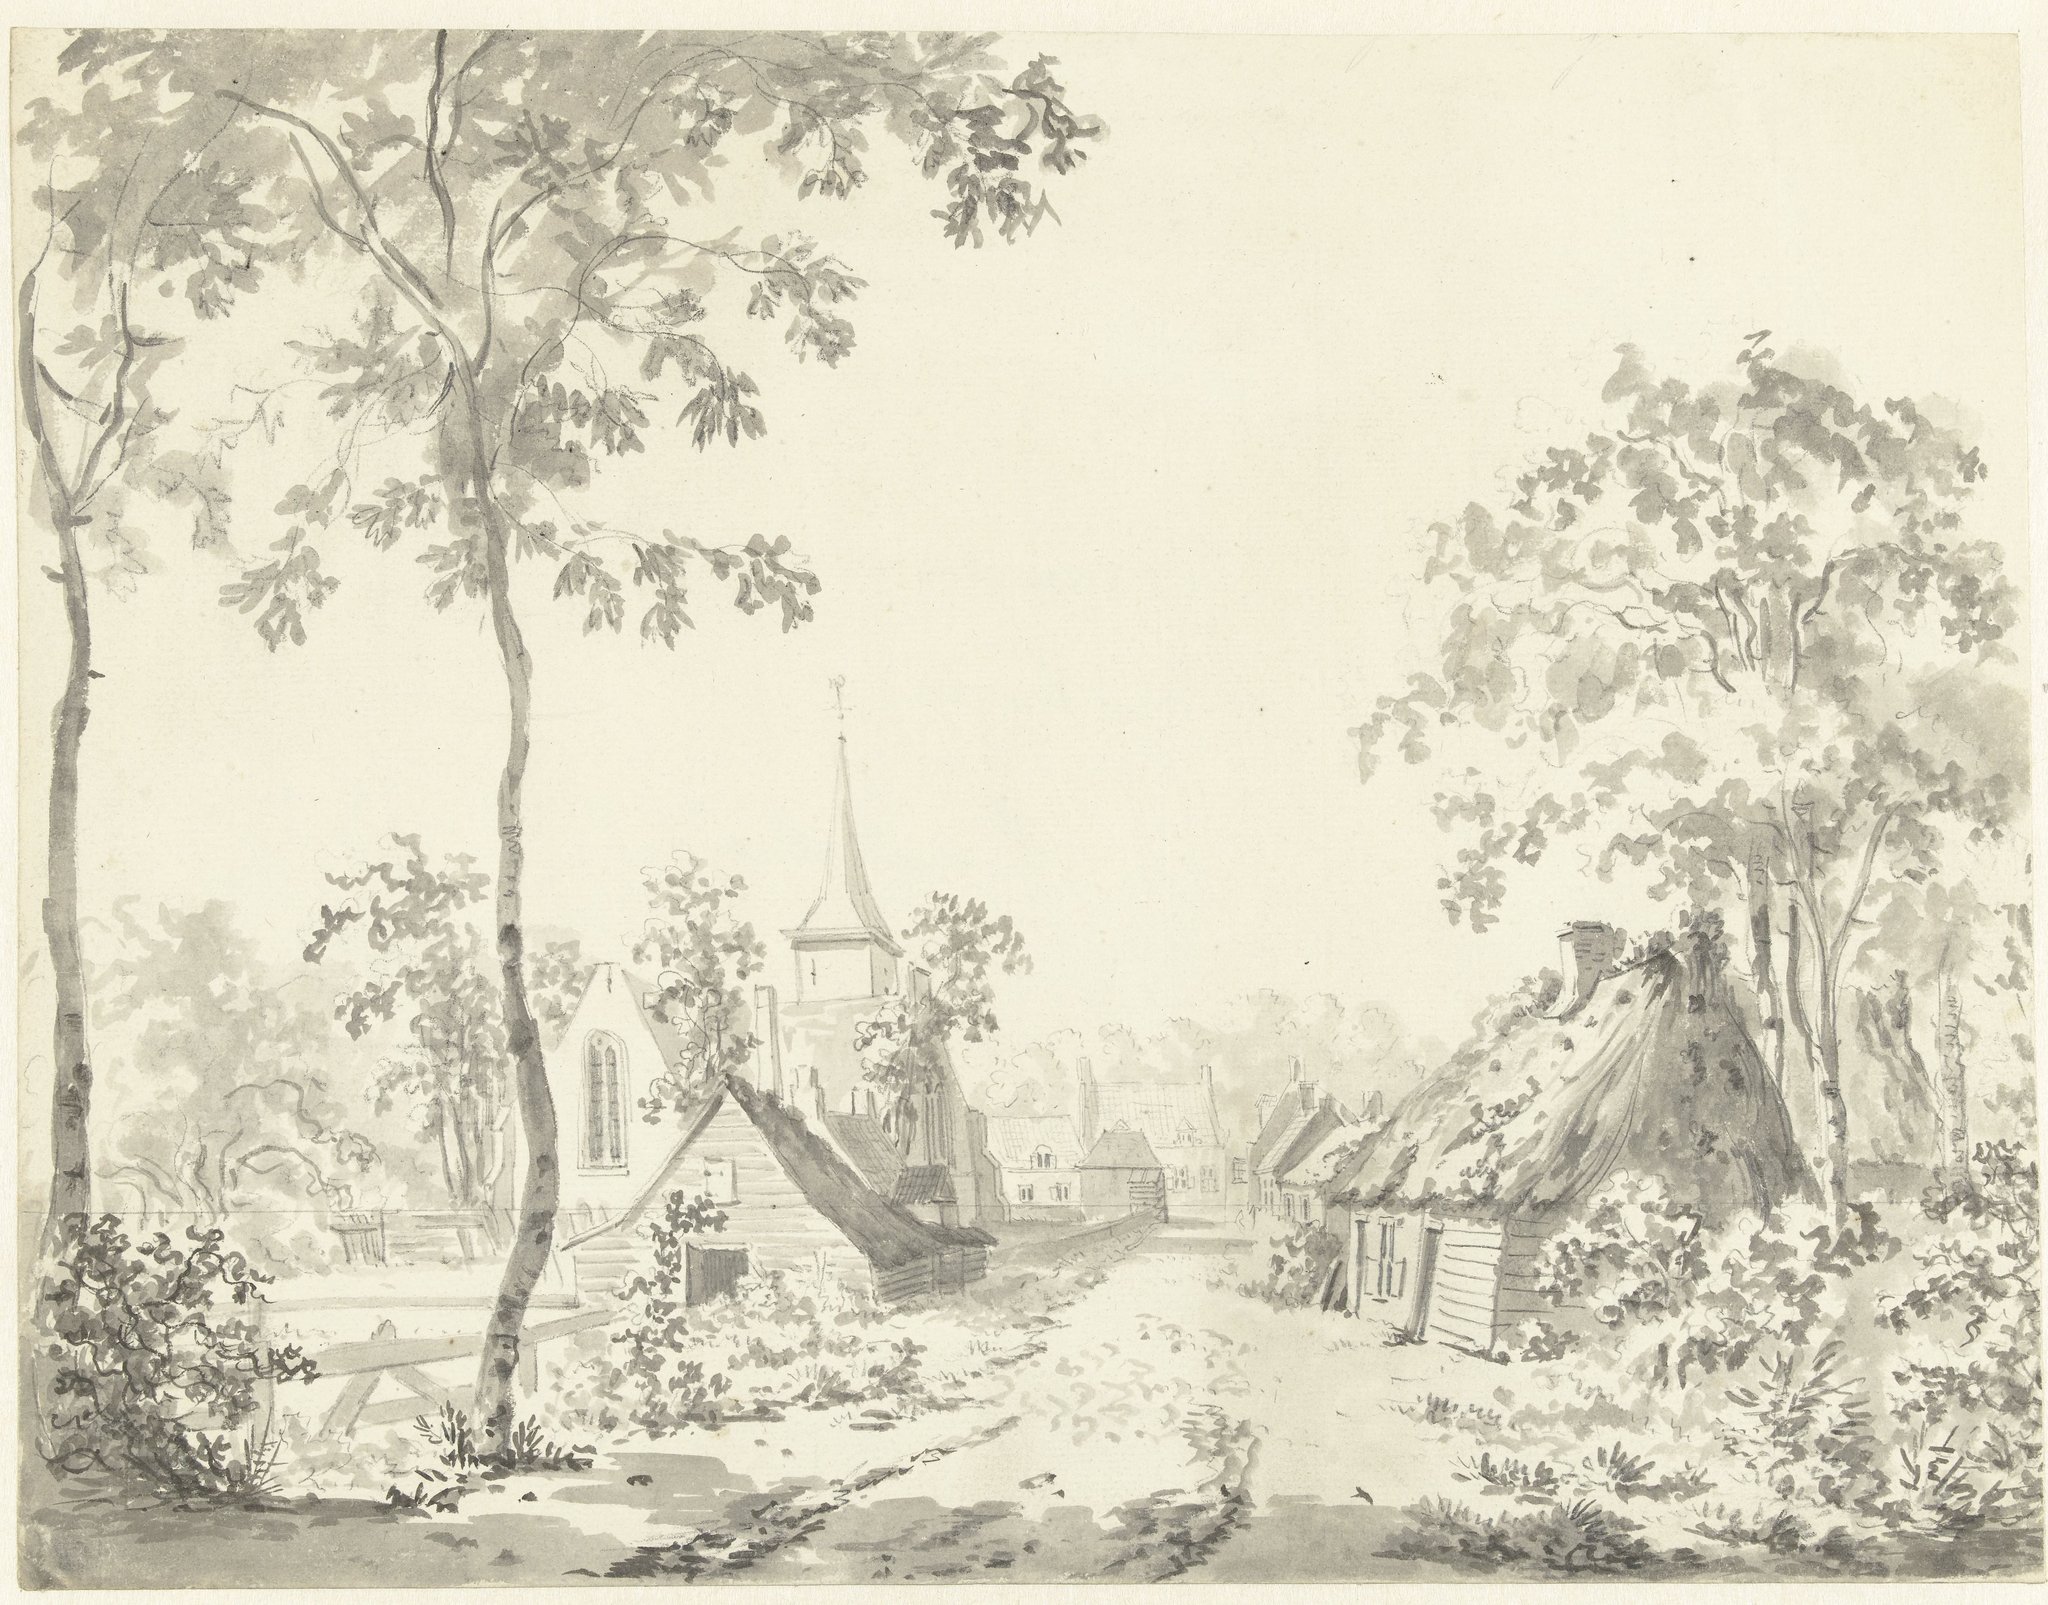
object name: drawing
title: Gezicht te Overzande op Zuid-Beveland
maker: Anonymous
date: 1700-1800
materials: paper, pencil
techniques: brush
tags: prospect of village, silhouette of village